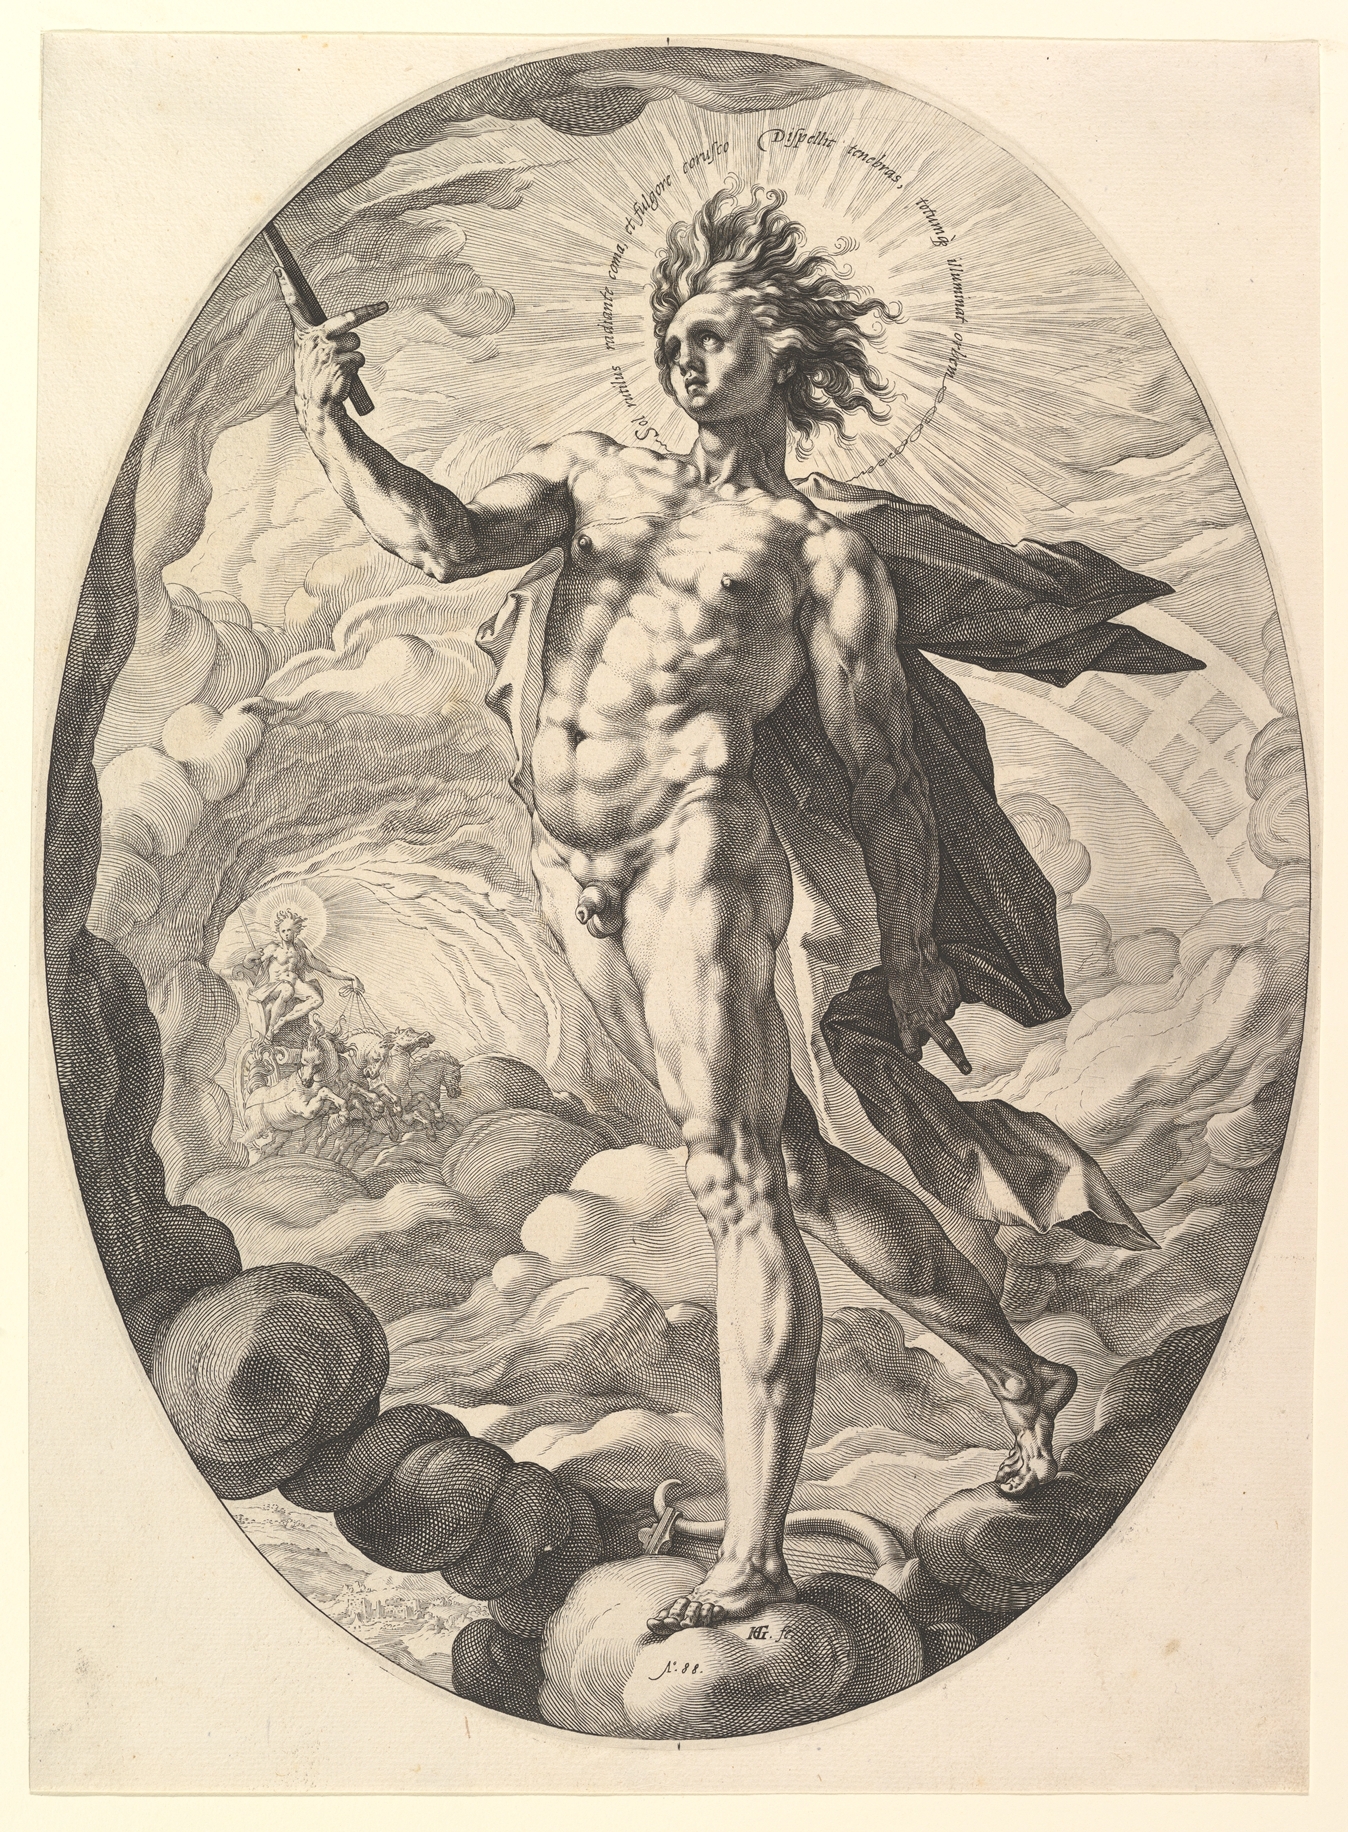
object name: print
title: Apollo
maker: hendrick goltzius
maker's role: artist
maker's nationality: netherlandish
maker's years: 1558-1617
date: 1588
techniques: engraving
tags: male nudes,apollo